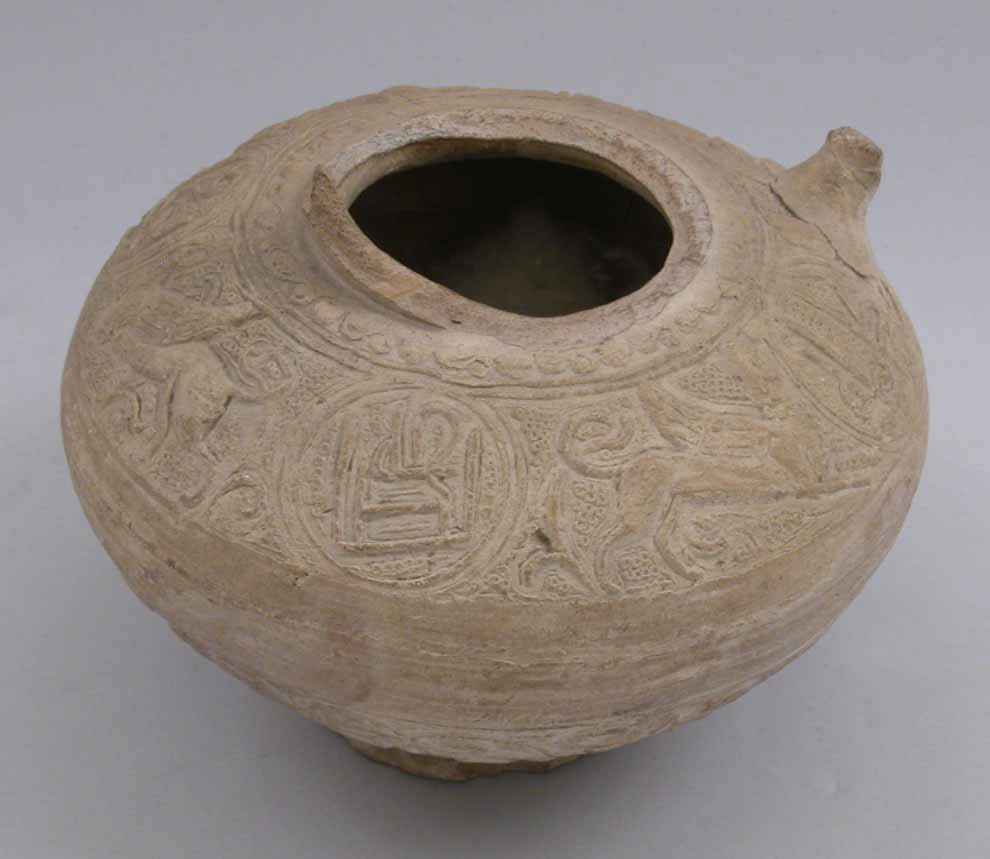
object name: jar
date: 1101-1200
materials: earthenware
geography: iraq